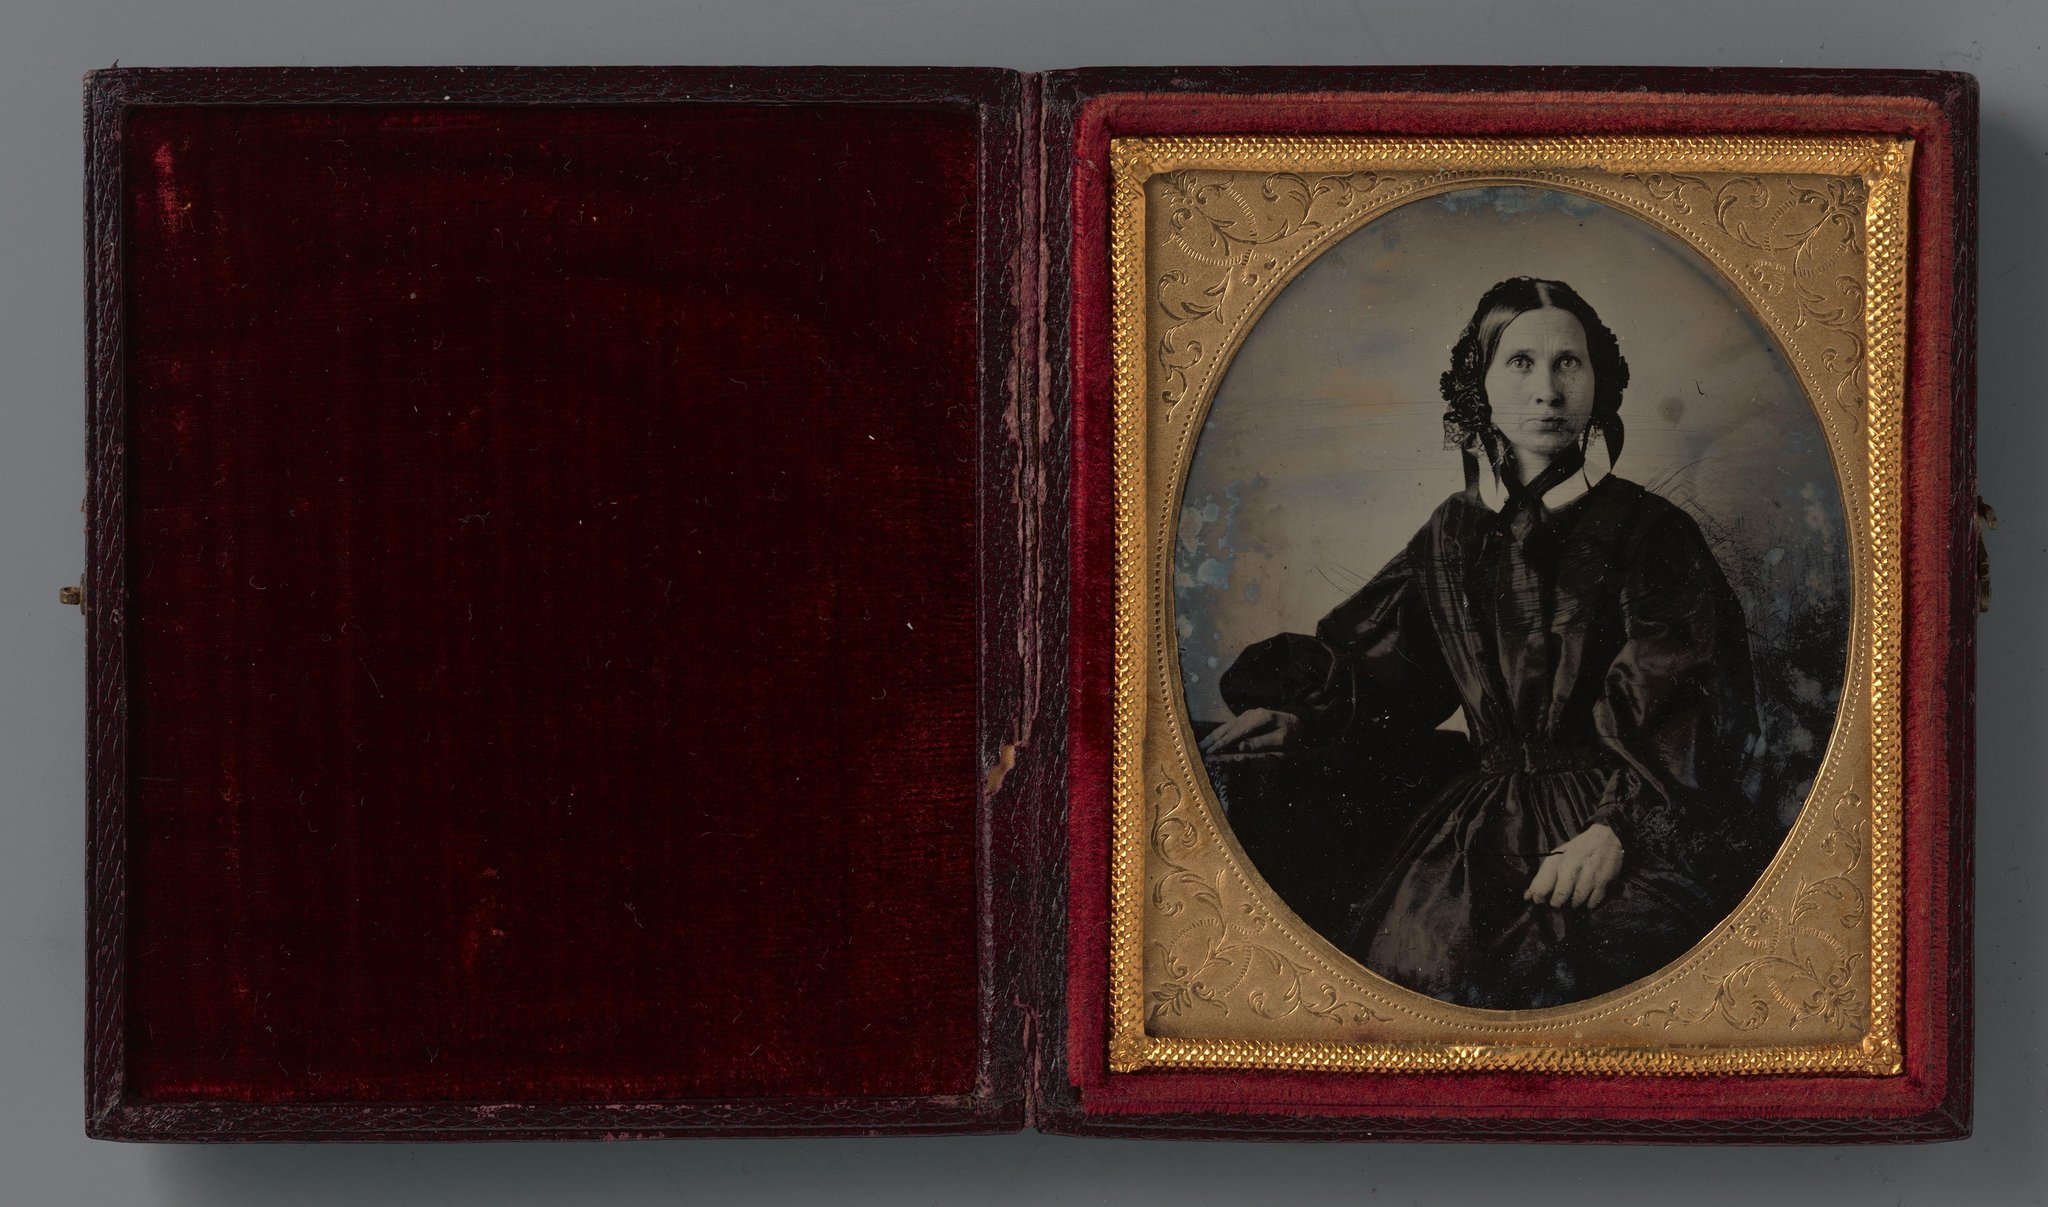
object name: photograph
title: Portret van een onbekende vrouw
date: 1855-1870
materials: glass, metal, velvet, wood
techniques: ambrotype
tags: historical persons - bb - woman